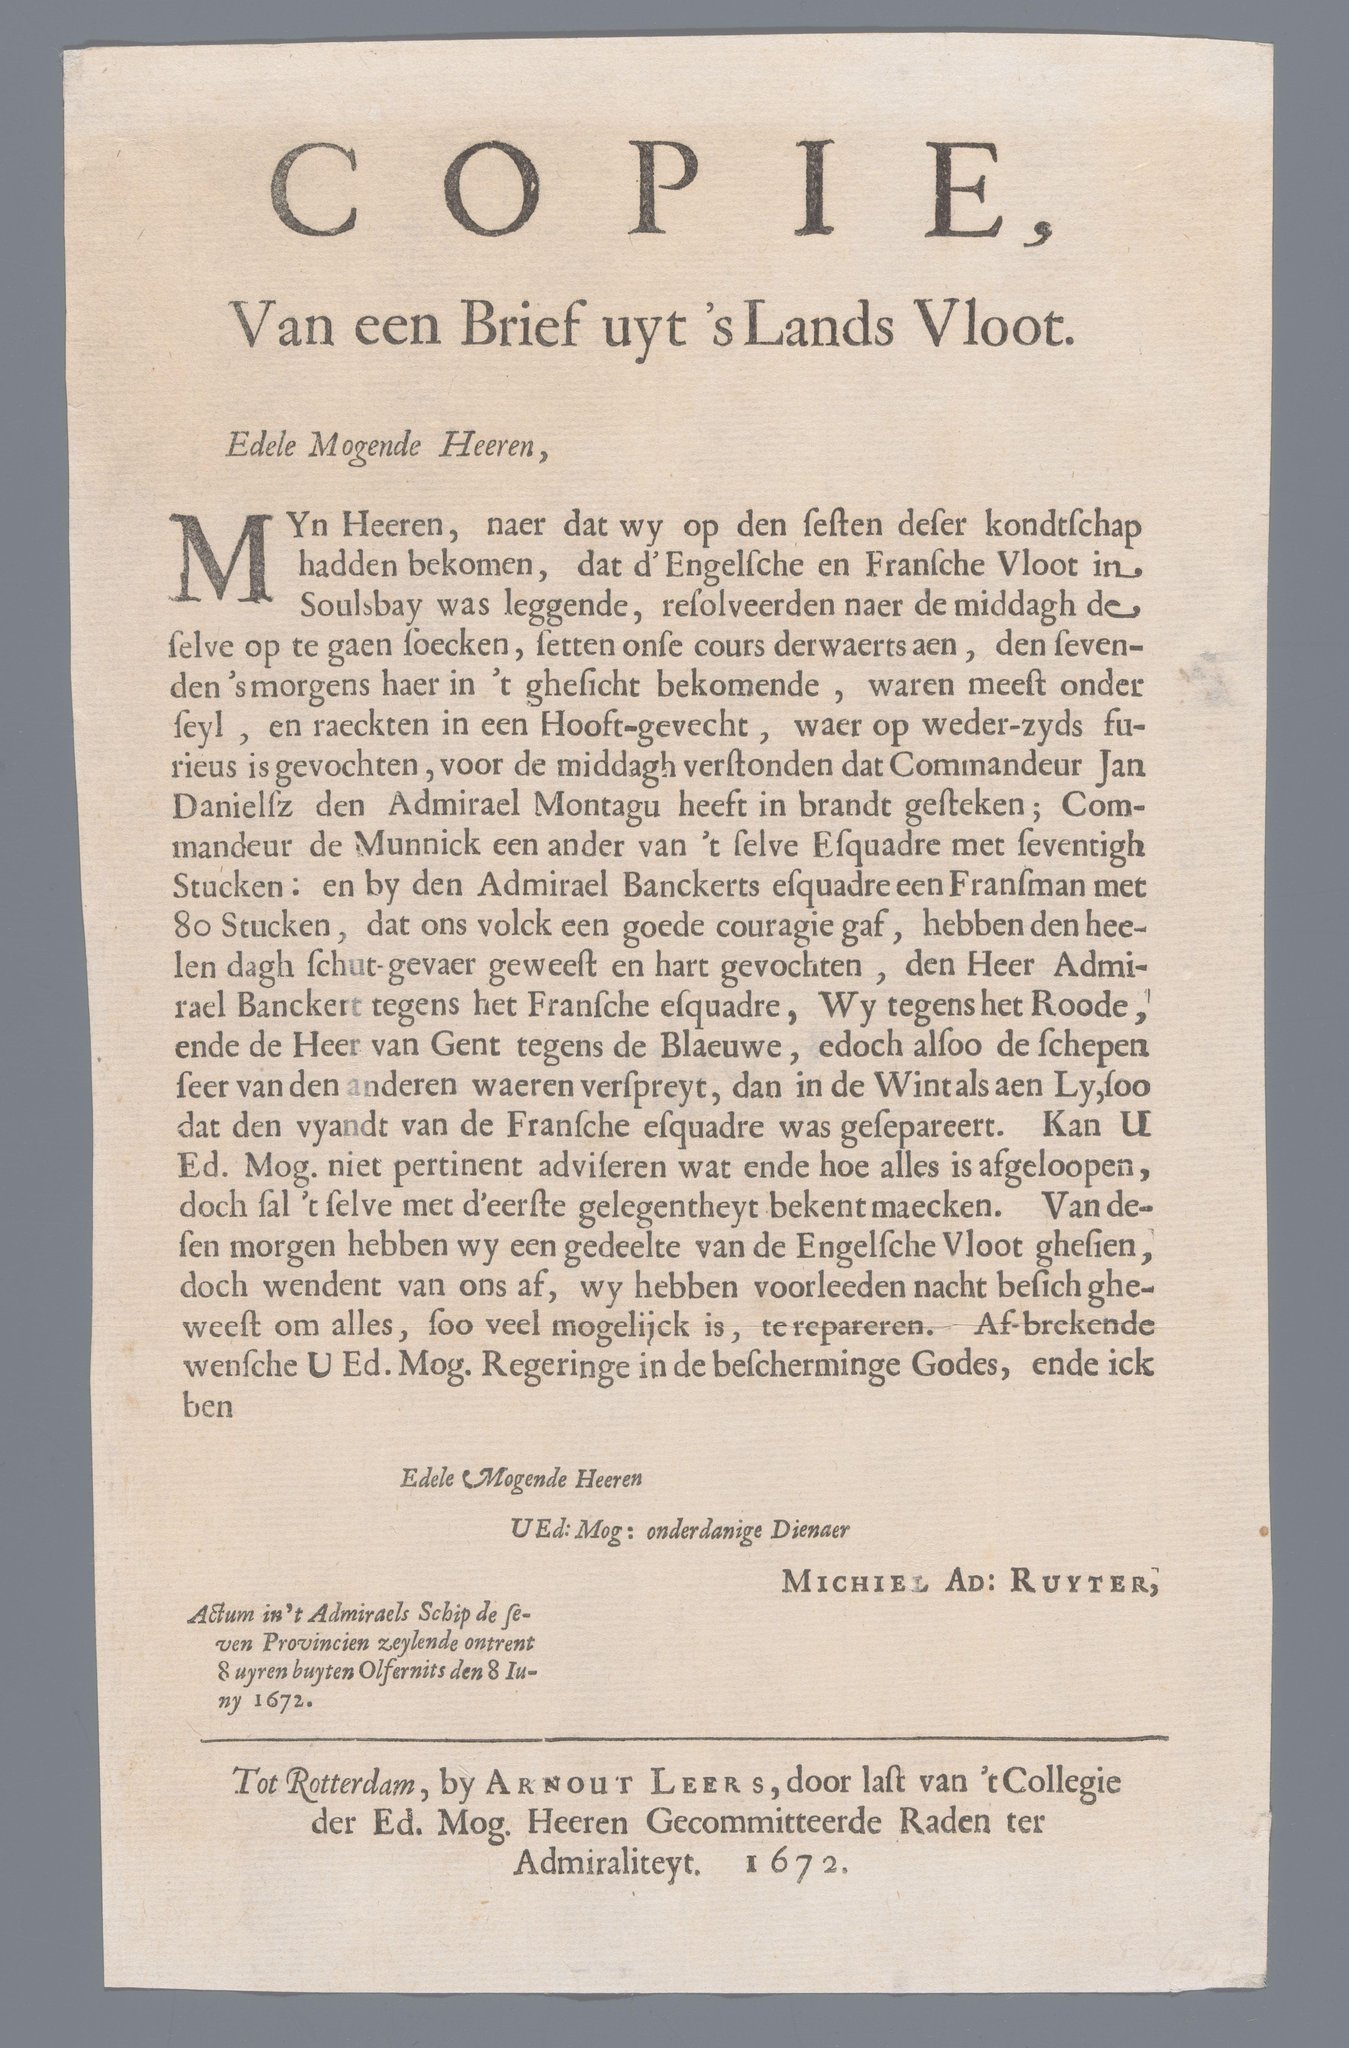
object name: letter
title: Copie van een Brief uyt 's Lands Vloot van 8 juni 1672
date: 1672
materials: paper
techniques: printing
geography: rotterdam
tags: flushing, michiel adriaenszoon de ruyter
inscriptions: date